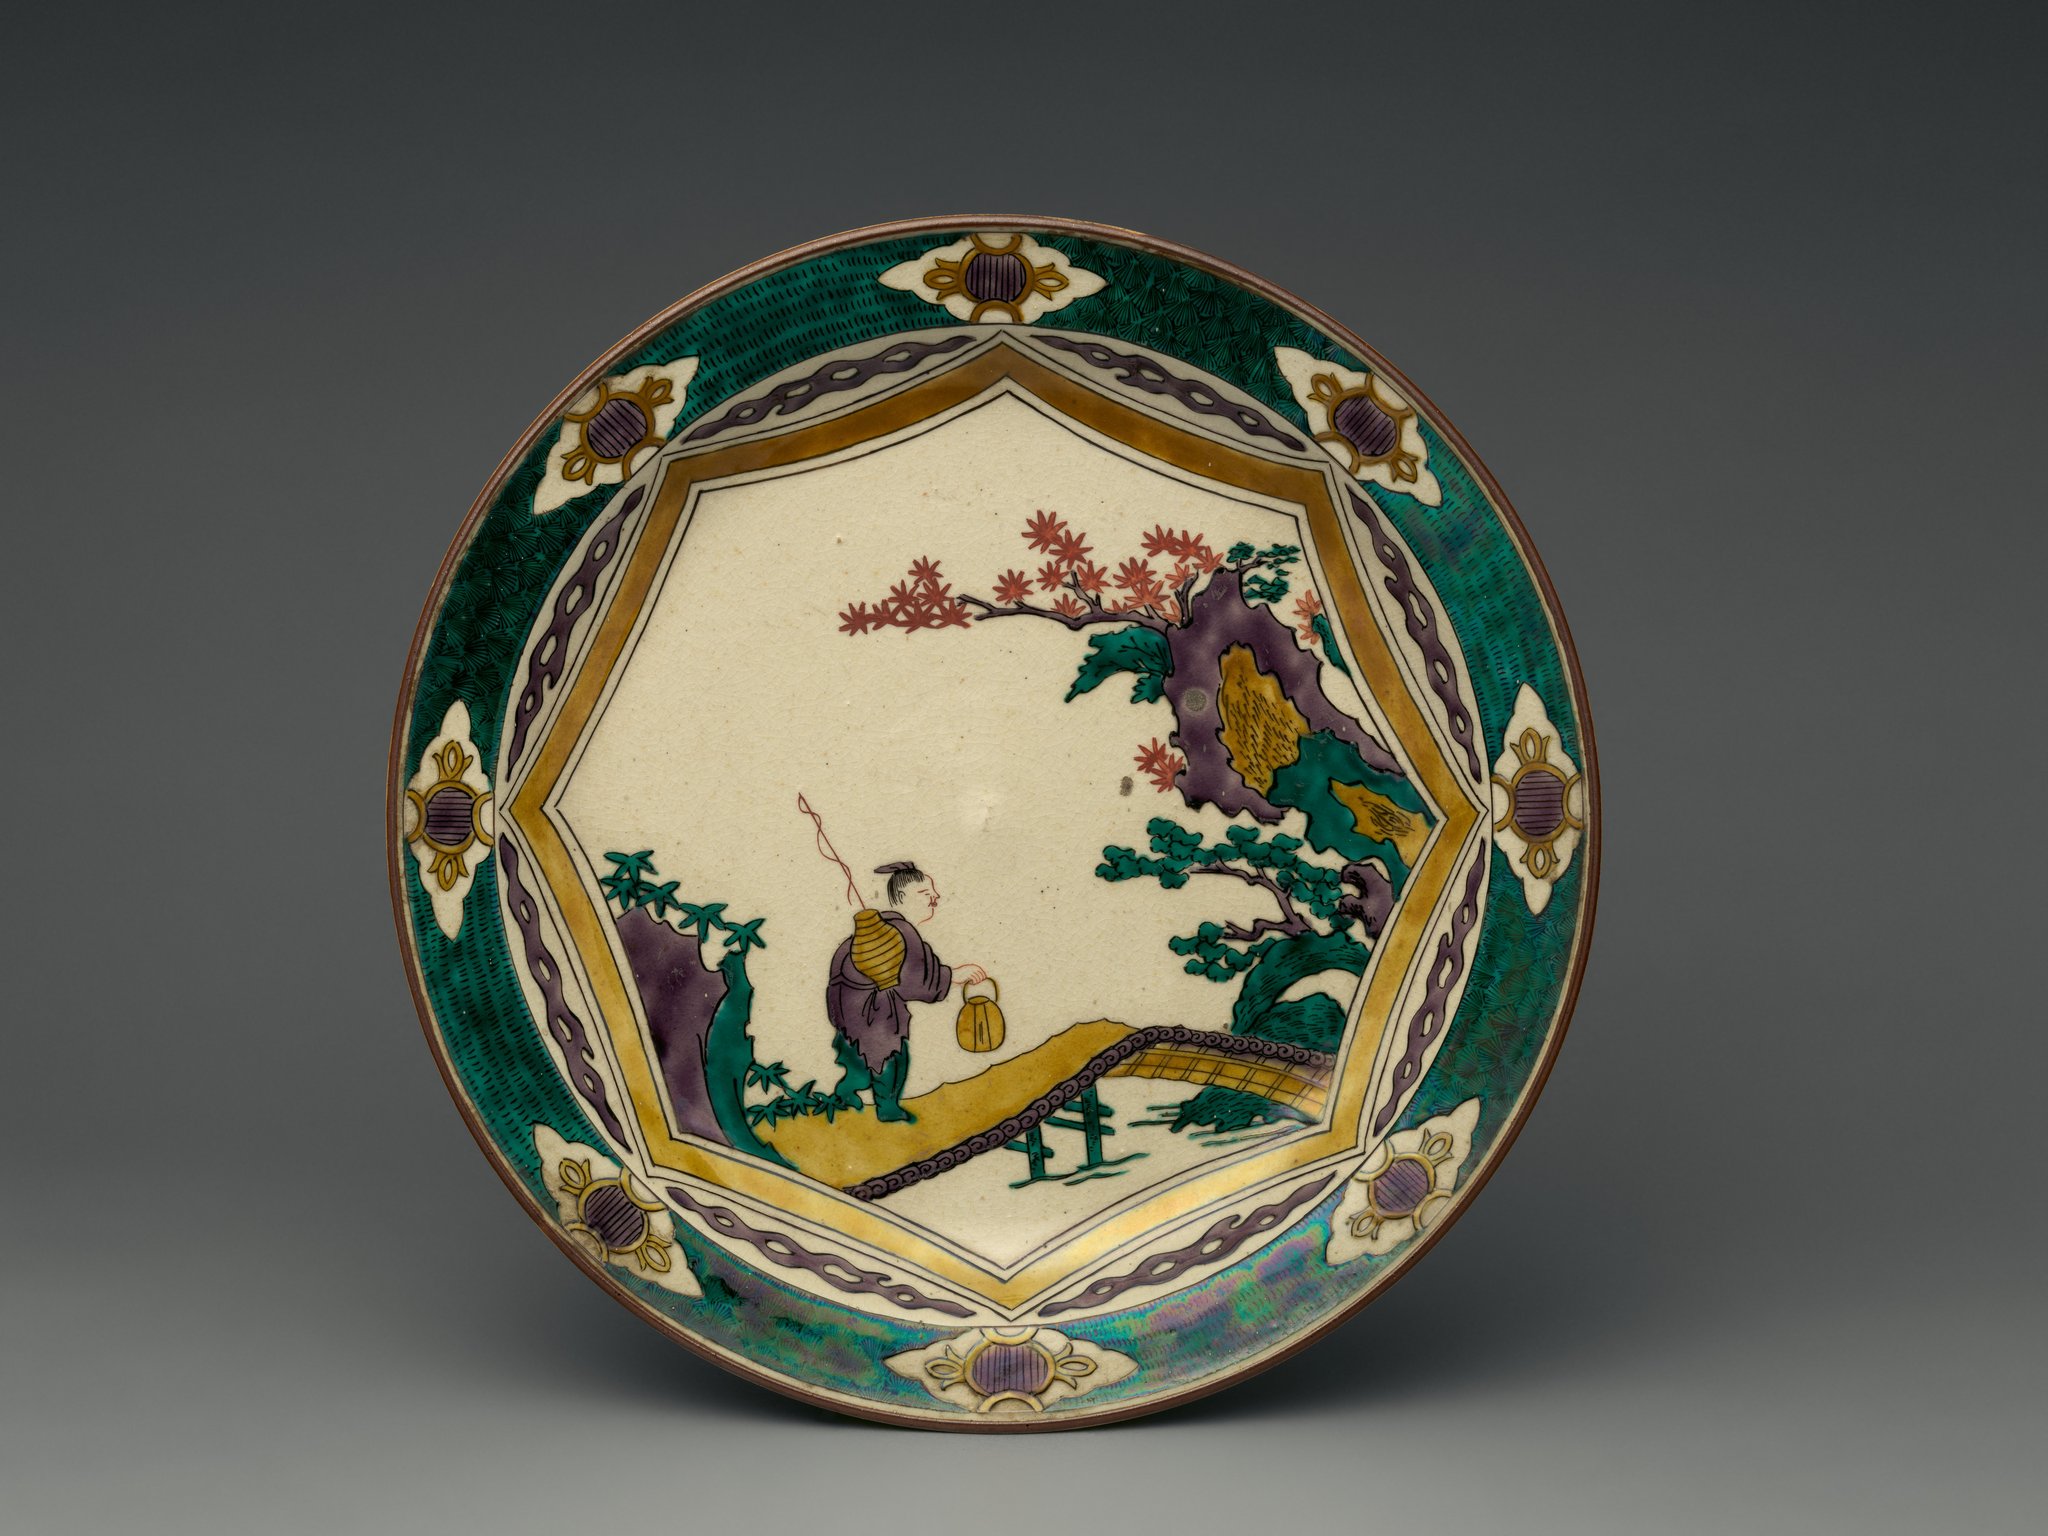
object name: dish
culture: japanese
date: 1834-1866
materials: enamel, porcelain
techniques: overglaze, polychrome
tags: men,flowers